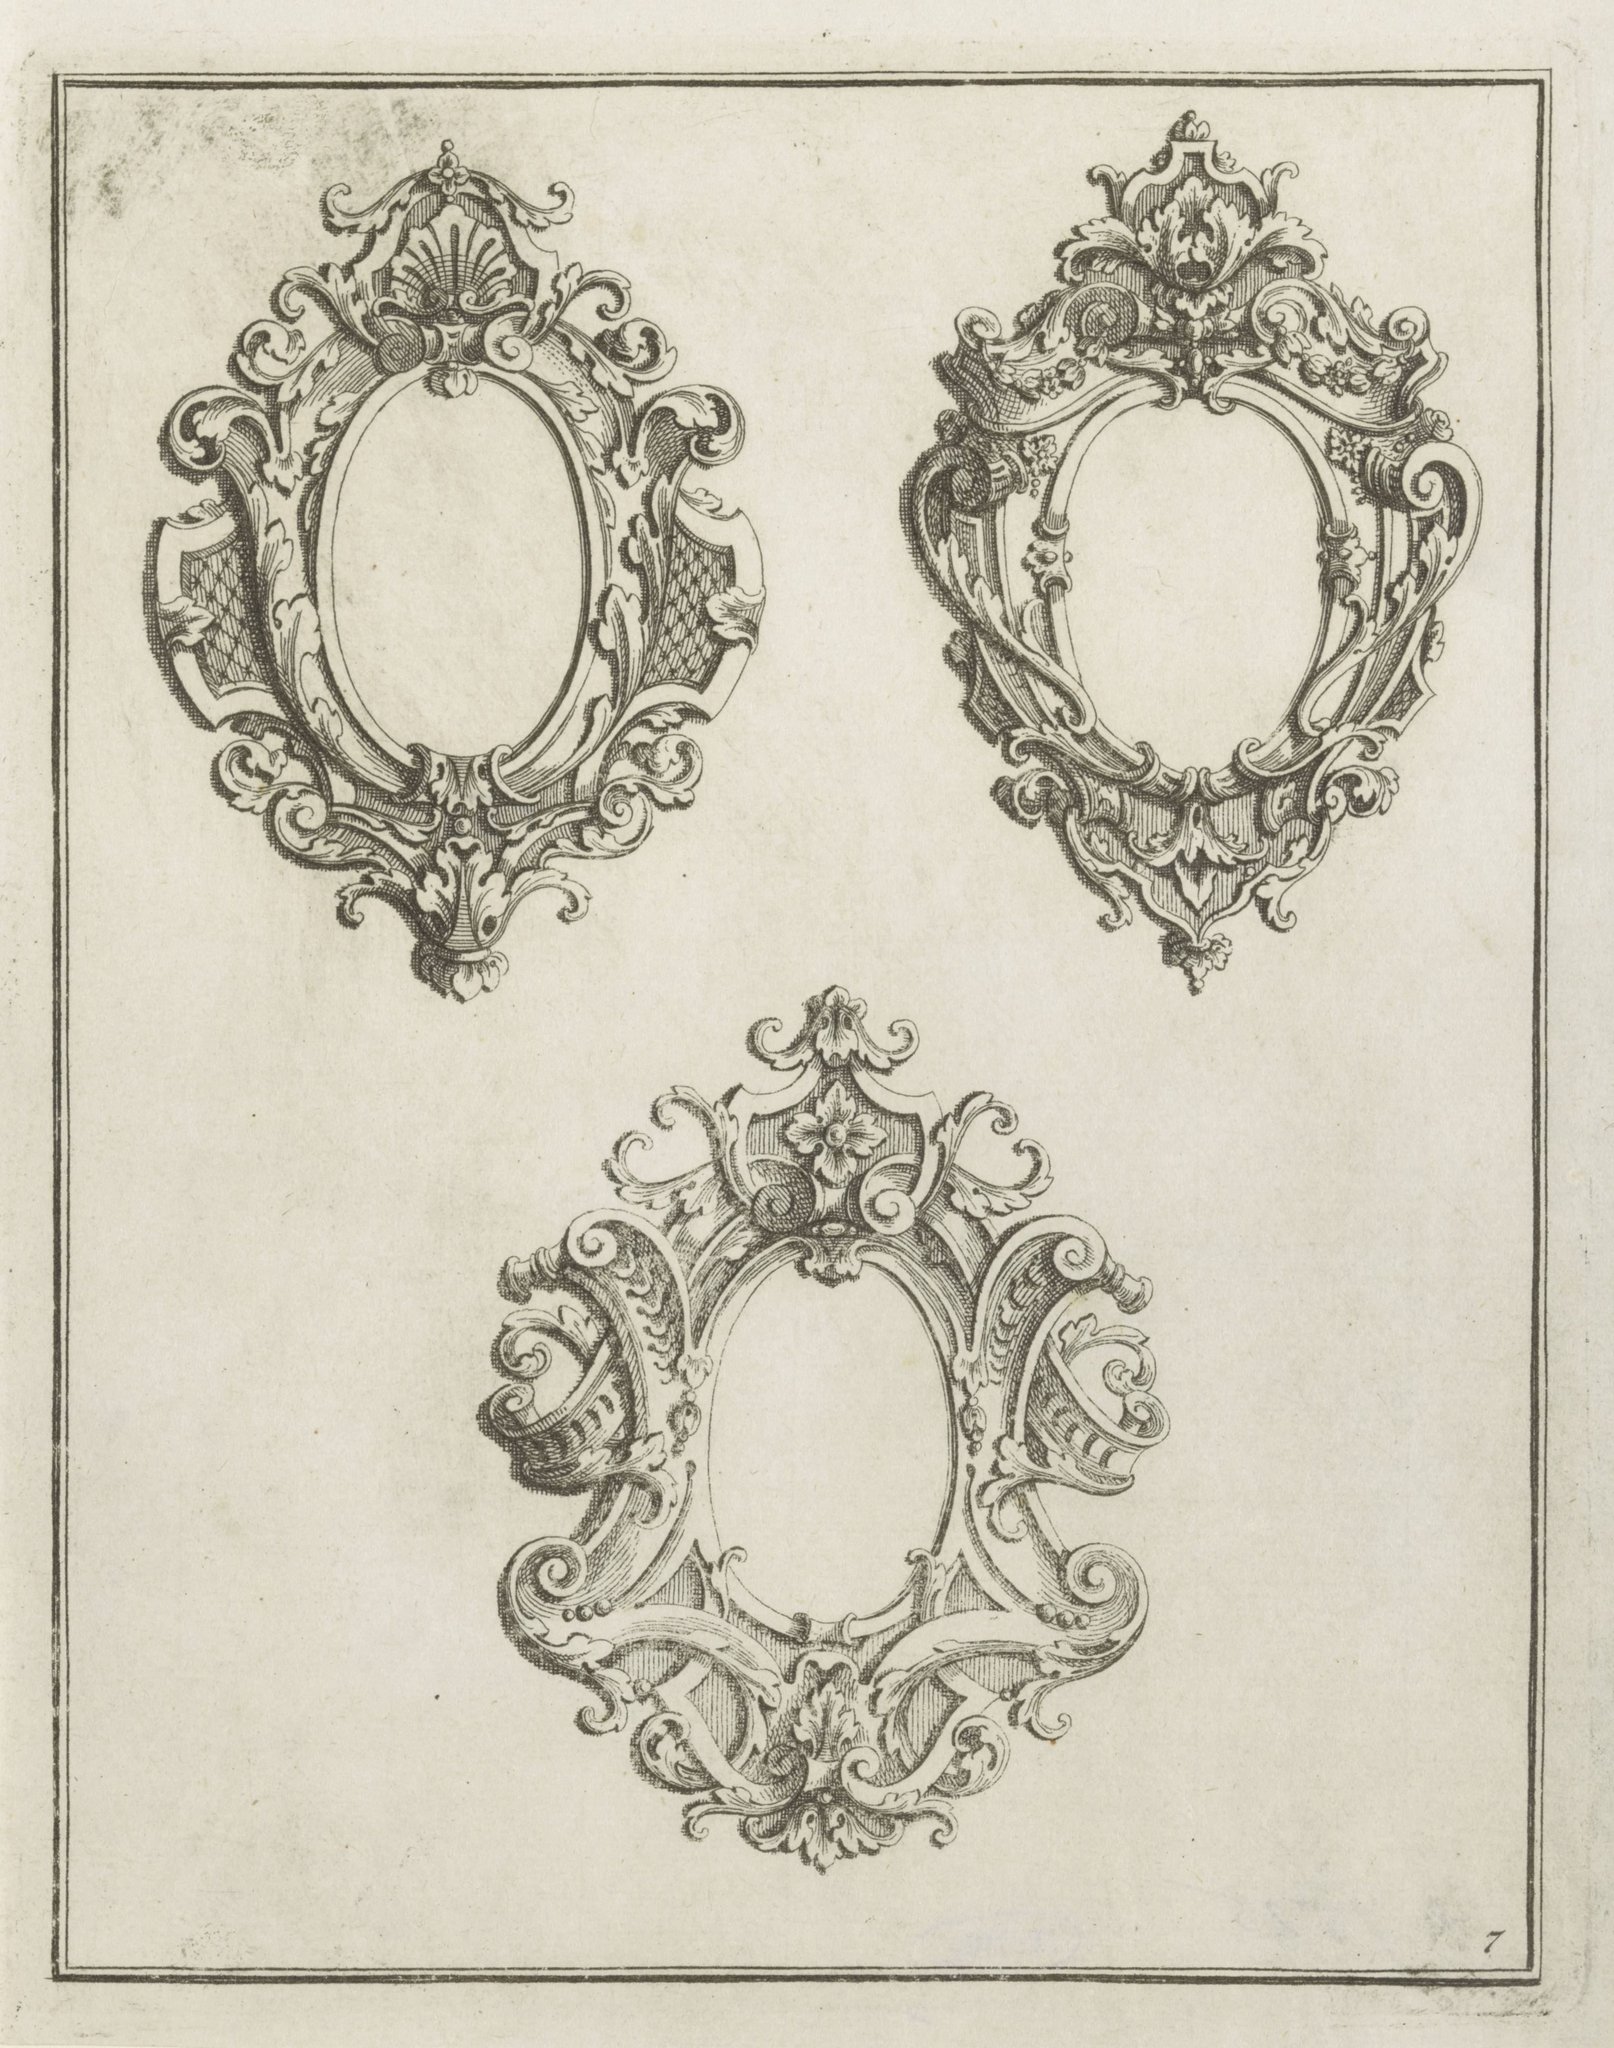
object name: ornament print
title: Unterschiedliche Art neu inventirter Schilder für allerhand professione nüzlich zu gebrauchen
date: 1726-1734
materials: paper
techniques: etching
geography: nuremberg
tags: rocaille ornament, acanthus ~ ornament, ornament ~ arabesque, 'laub- und bandelwerk' ~ ornament, ornament ~ cartouche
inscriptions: collector's mark: Lugt 2228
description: Links boven een omlijsting met arabesken, vlechtwerk en aan de bovenzijde een rocaille ornament. Rechts boven een omlijsting met arabesken en acanthusbladeren aan de bovenzijde. De onderste omlijsting is versierd met arabesken, bladwerk en aan de bovenzijde een bloemmotief.